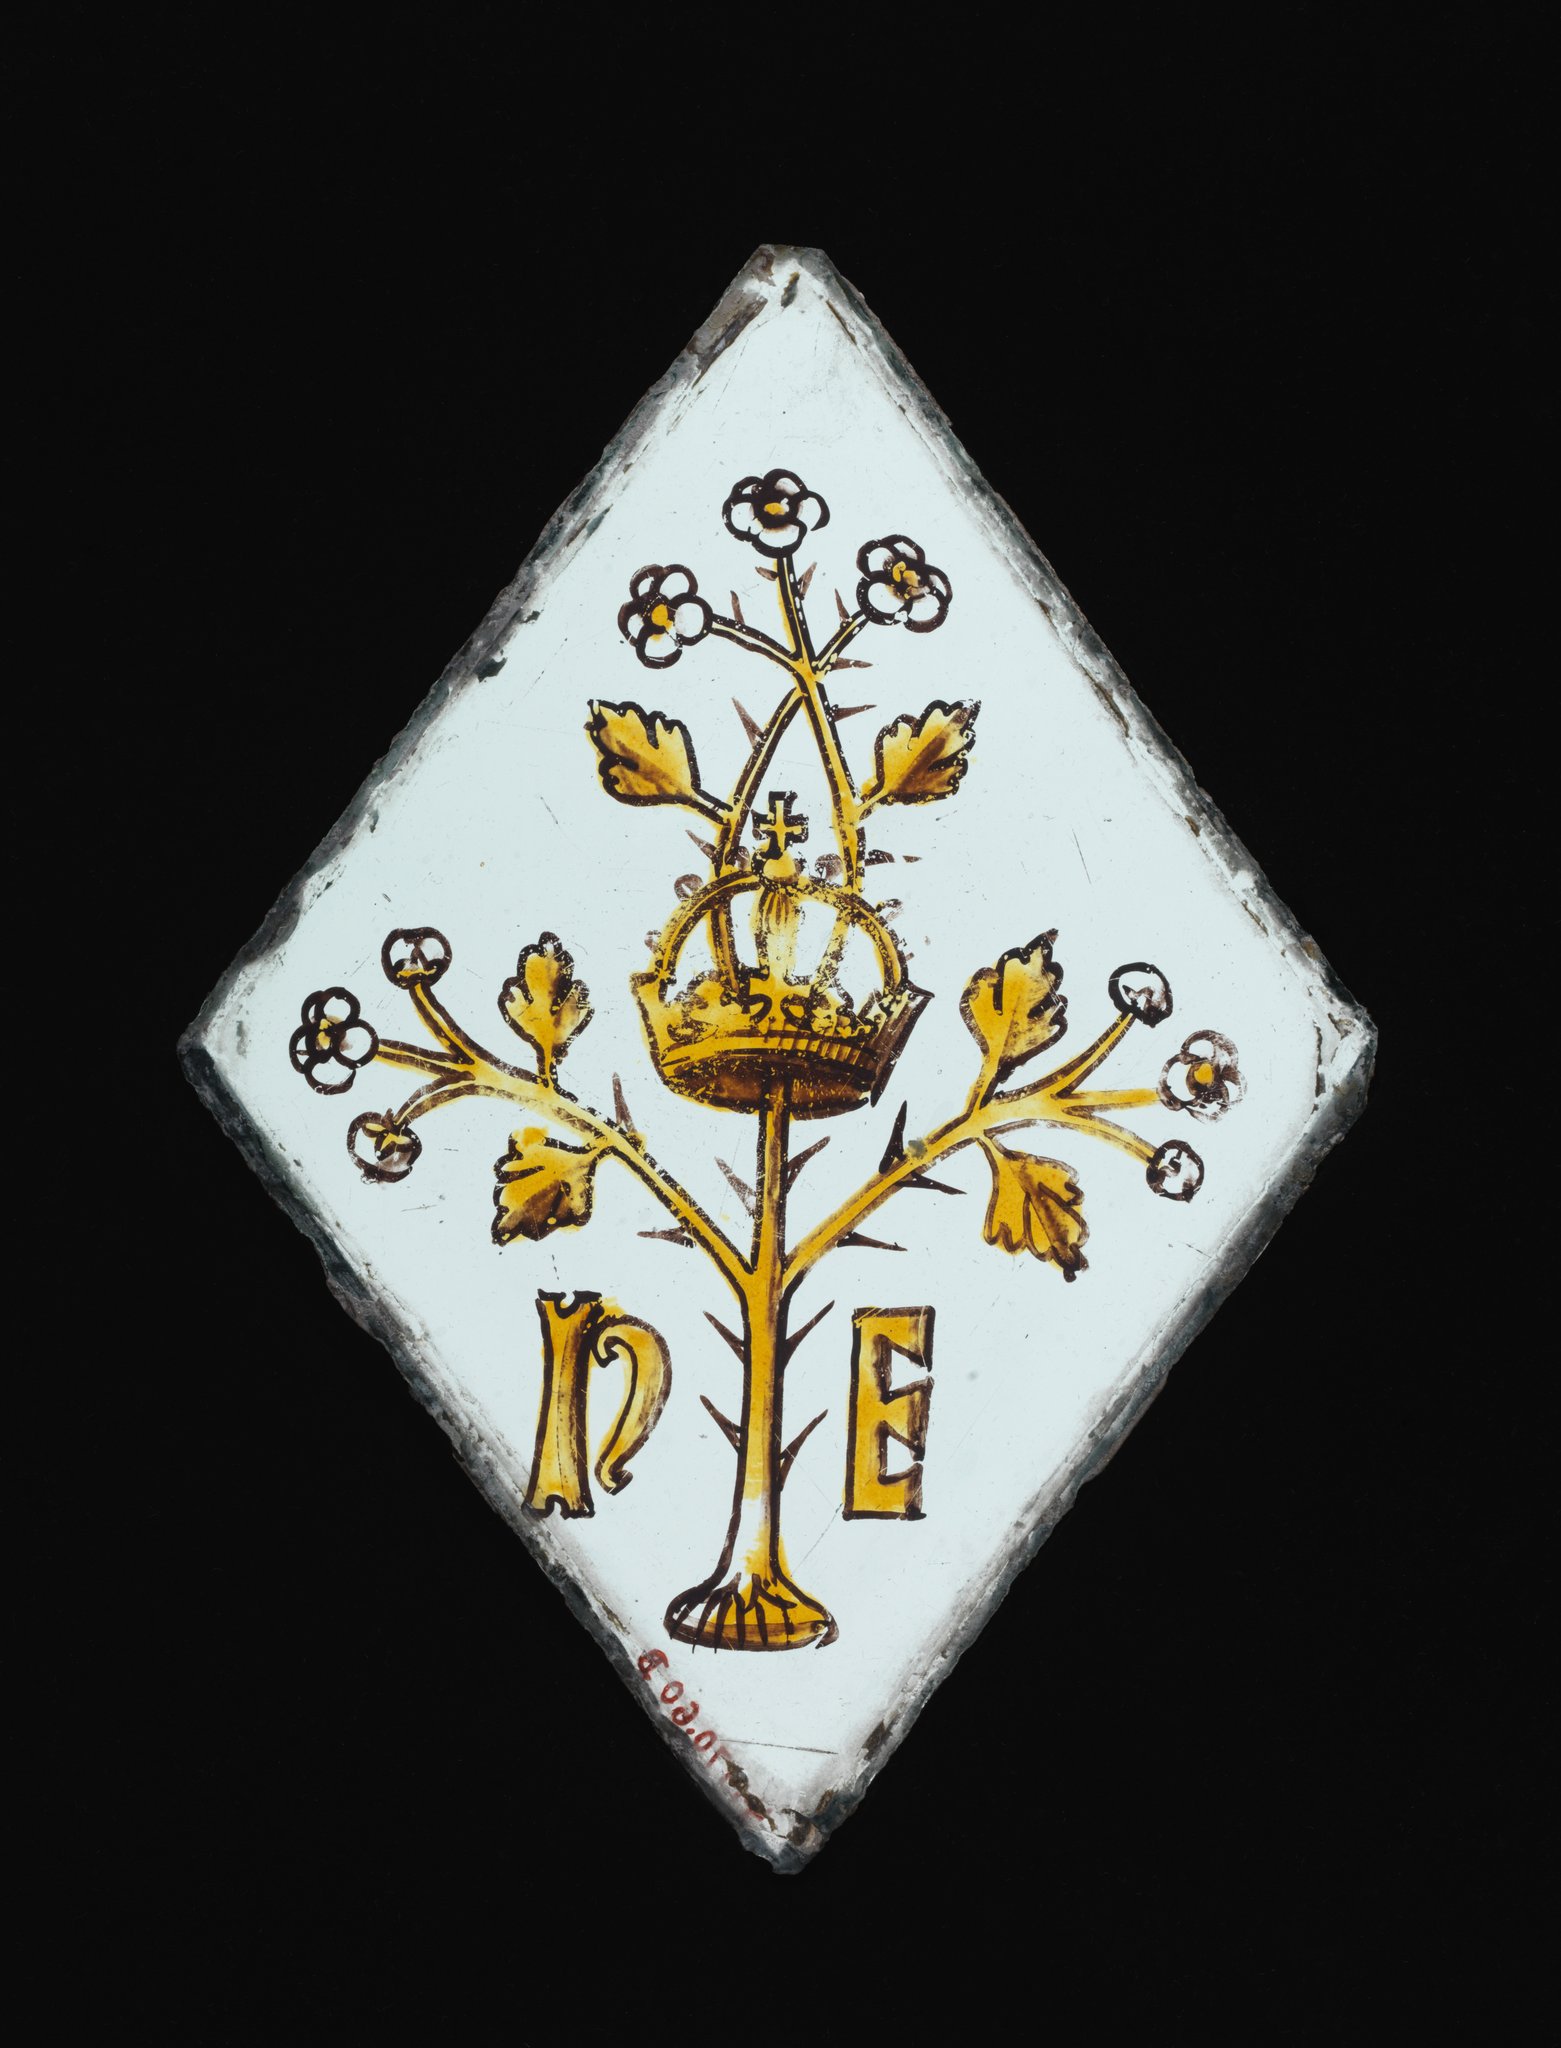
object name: quarry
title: Quarry (one of a pair)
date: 1501-1533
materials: glass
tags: crowns